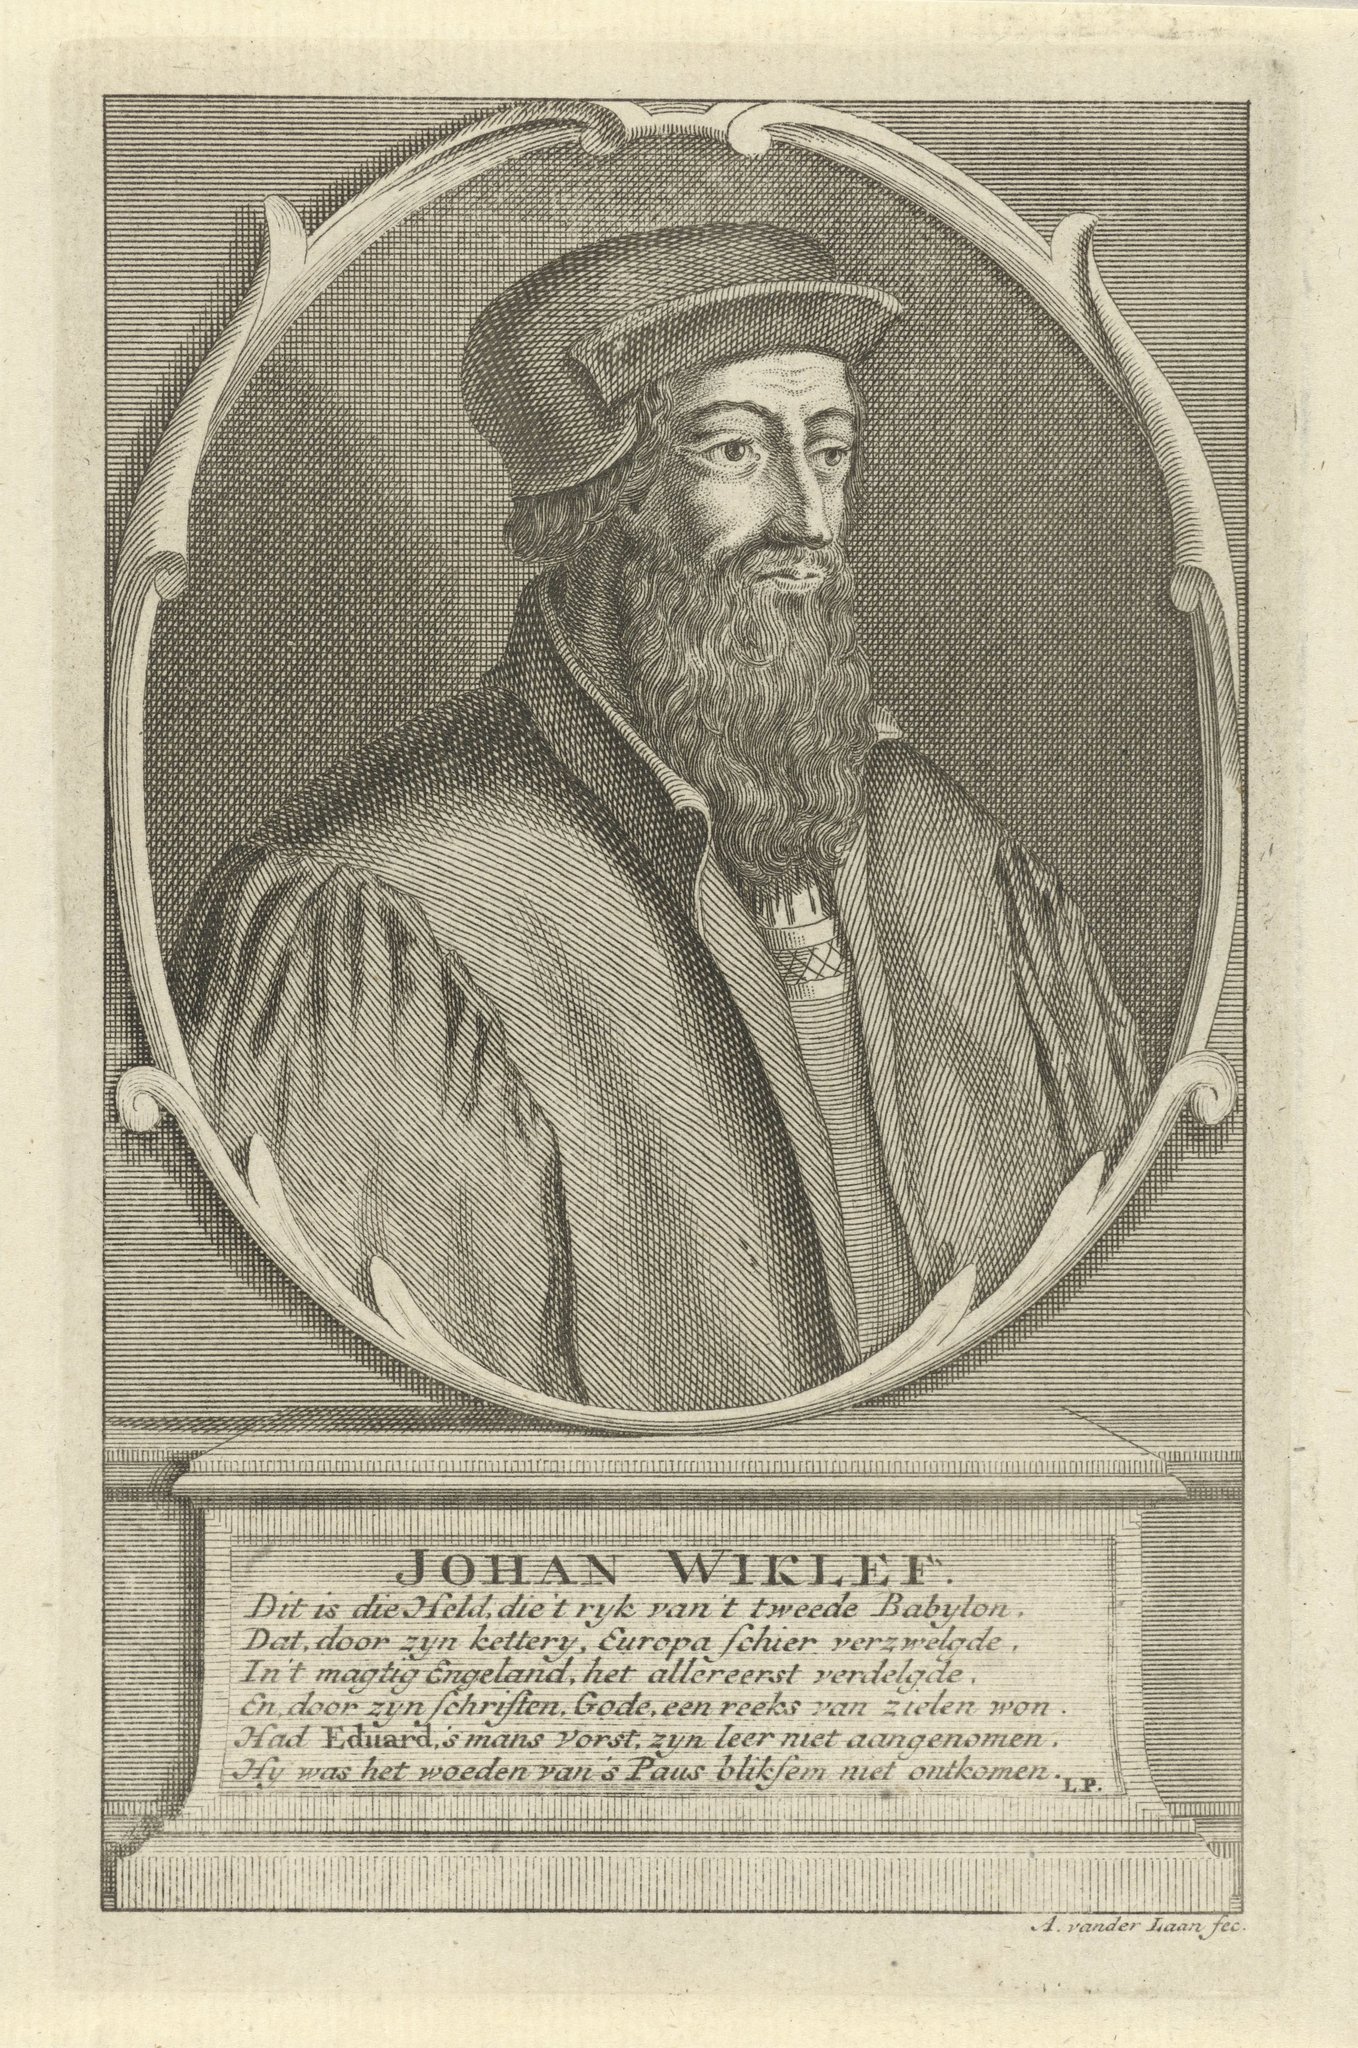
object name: print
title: Portret van John Wyclif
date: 1730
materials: paper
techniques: engraving, etching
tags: lutterworth, theoloog, john wyclif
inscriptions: collector's mark: Lugt 2228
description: Portretbuste in ovaal naar rechts van de Engelse theoloog John Wyclif, met hoofddeksel. Het portret steunt op een sokkel waarop de naam van de geportretteerde staat, gevolgd door een zesregelig Nederlands vers.